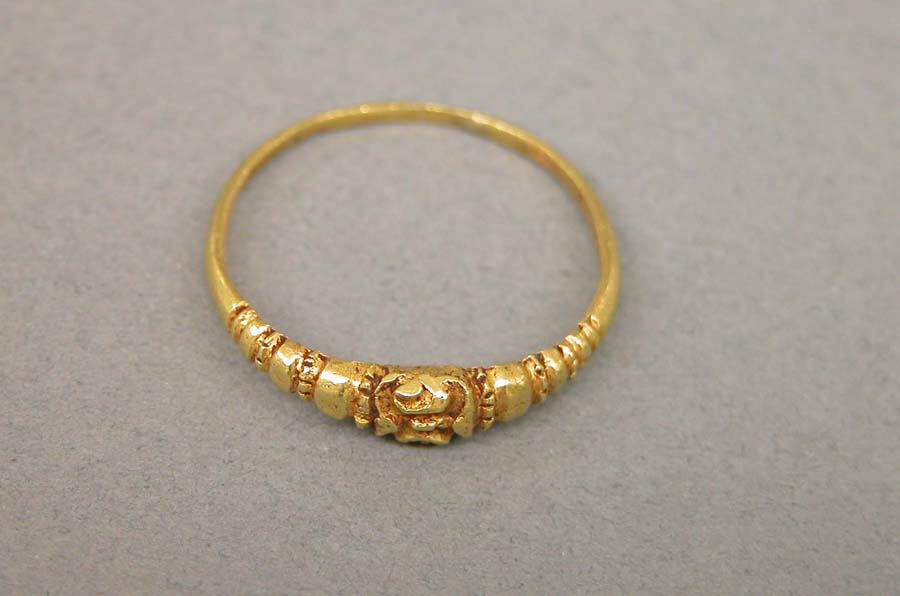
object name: ring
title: Ring with Ribbed and Notched Hoop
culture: indonesian, javanese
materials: gold